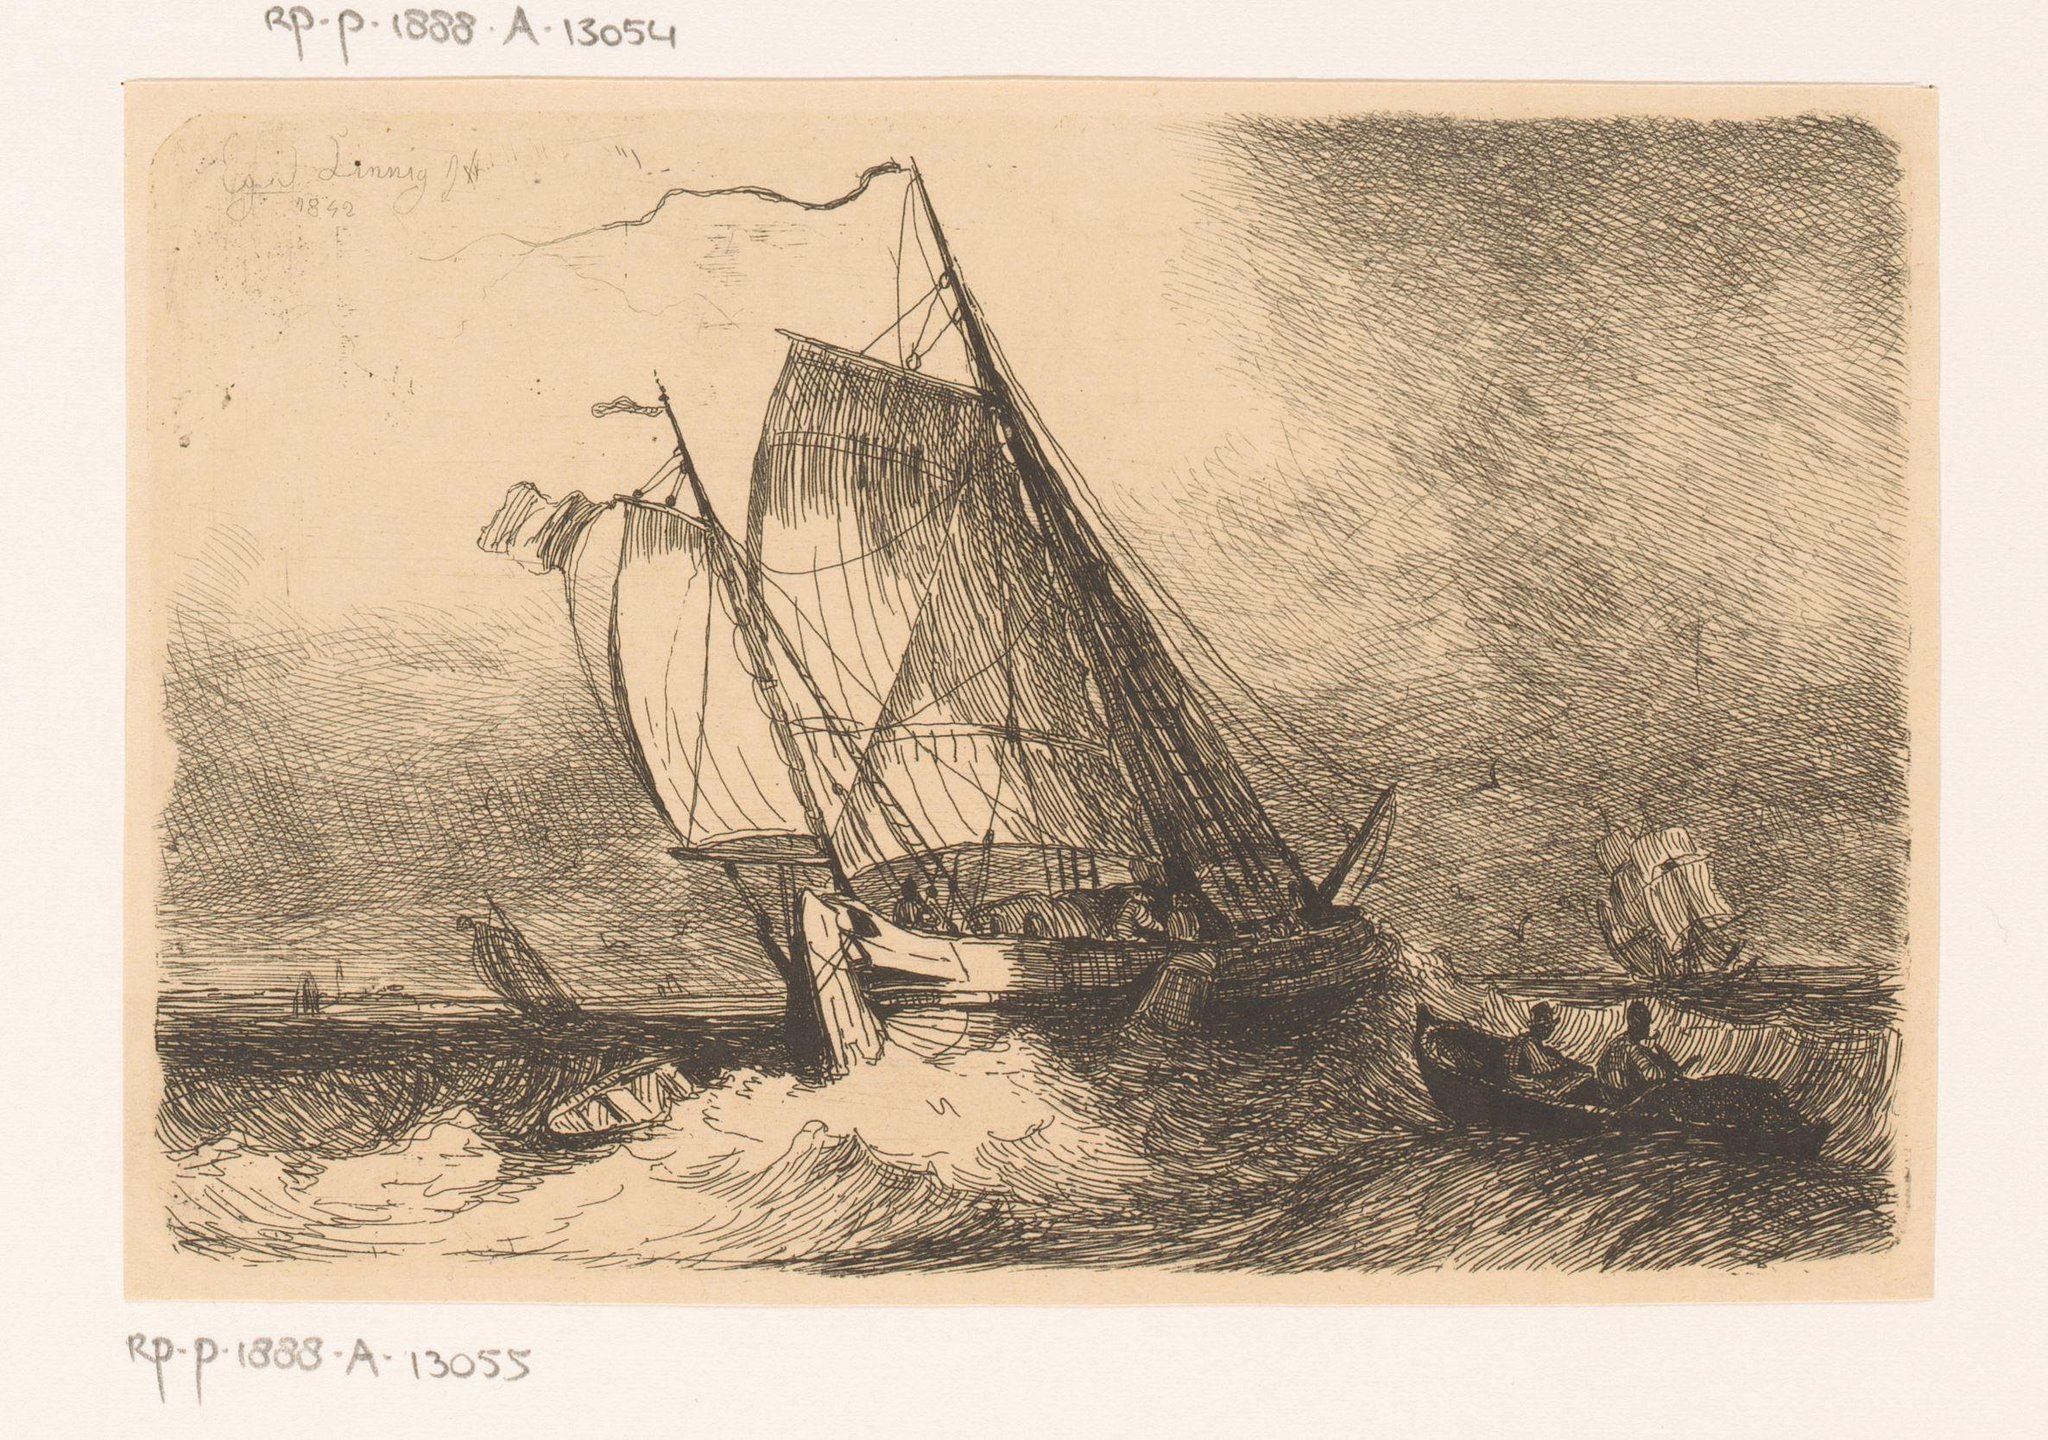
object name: print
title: Zeilschepen en een roeiboot op onrustige zee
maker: egidius linnig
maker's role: draughtsman, print maker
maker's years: 1821-1860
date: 1842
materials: paper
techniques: etching, intaglio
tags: sailing-ship, sailing-boat, rowing-boat, canoe, etc.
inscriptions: collector's mark: Lugt 2228